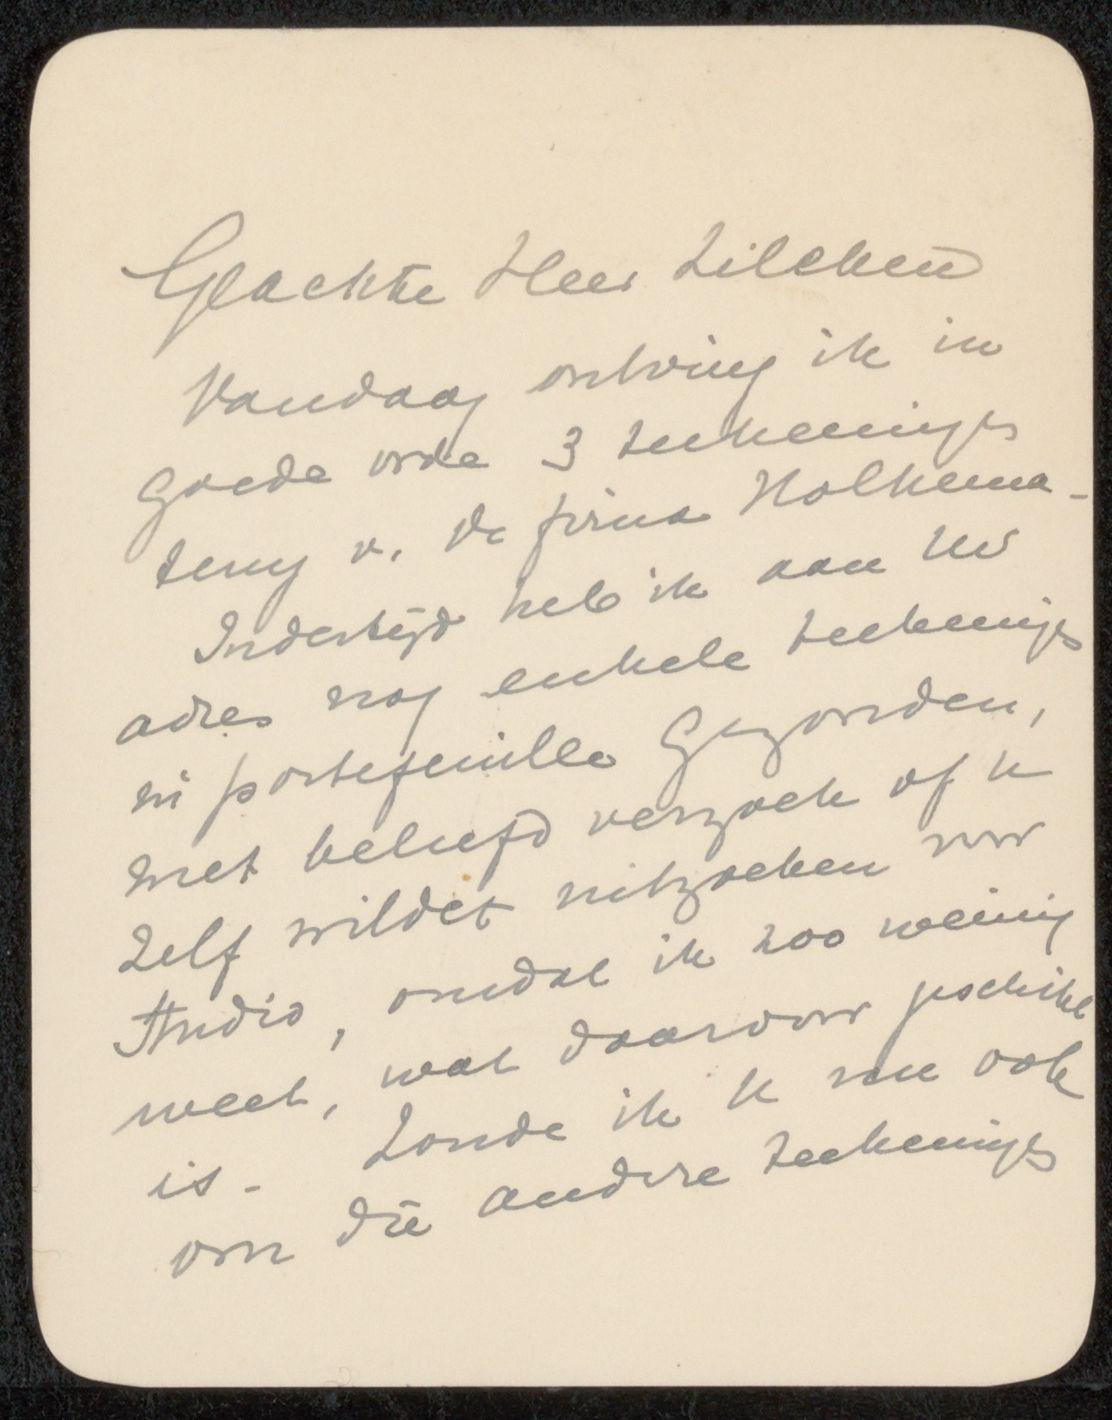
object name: letter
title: Brief aan Philip Zilcken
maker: maria baukema-philipse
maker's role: draughtsman, painter, print maker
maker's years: 1863-1952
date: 1911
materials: cardboard, ink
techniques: pen, writing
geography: arnhem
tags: publisher, philip zilcken, drawing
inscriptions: collector's mark: ‘RPK’